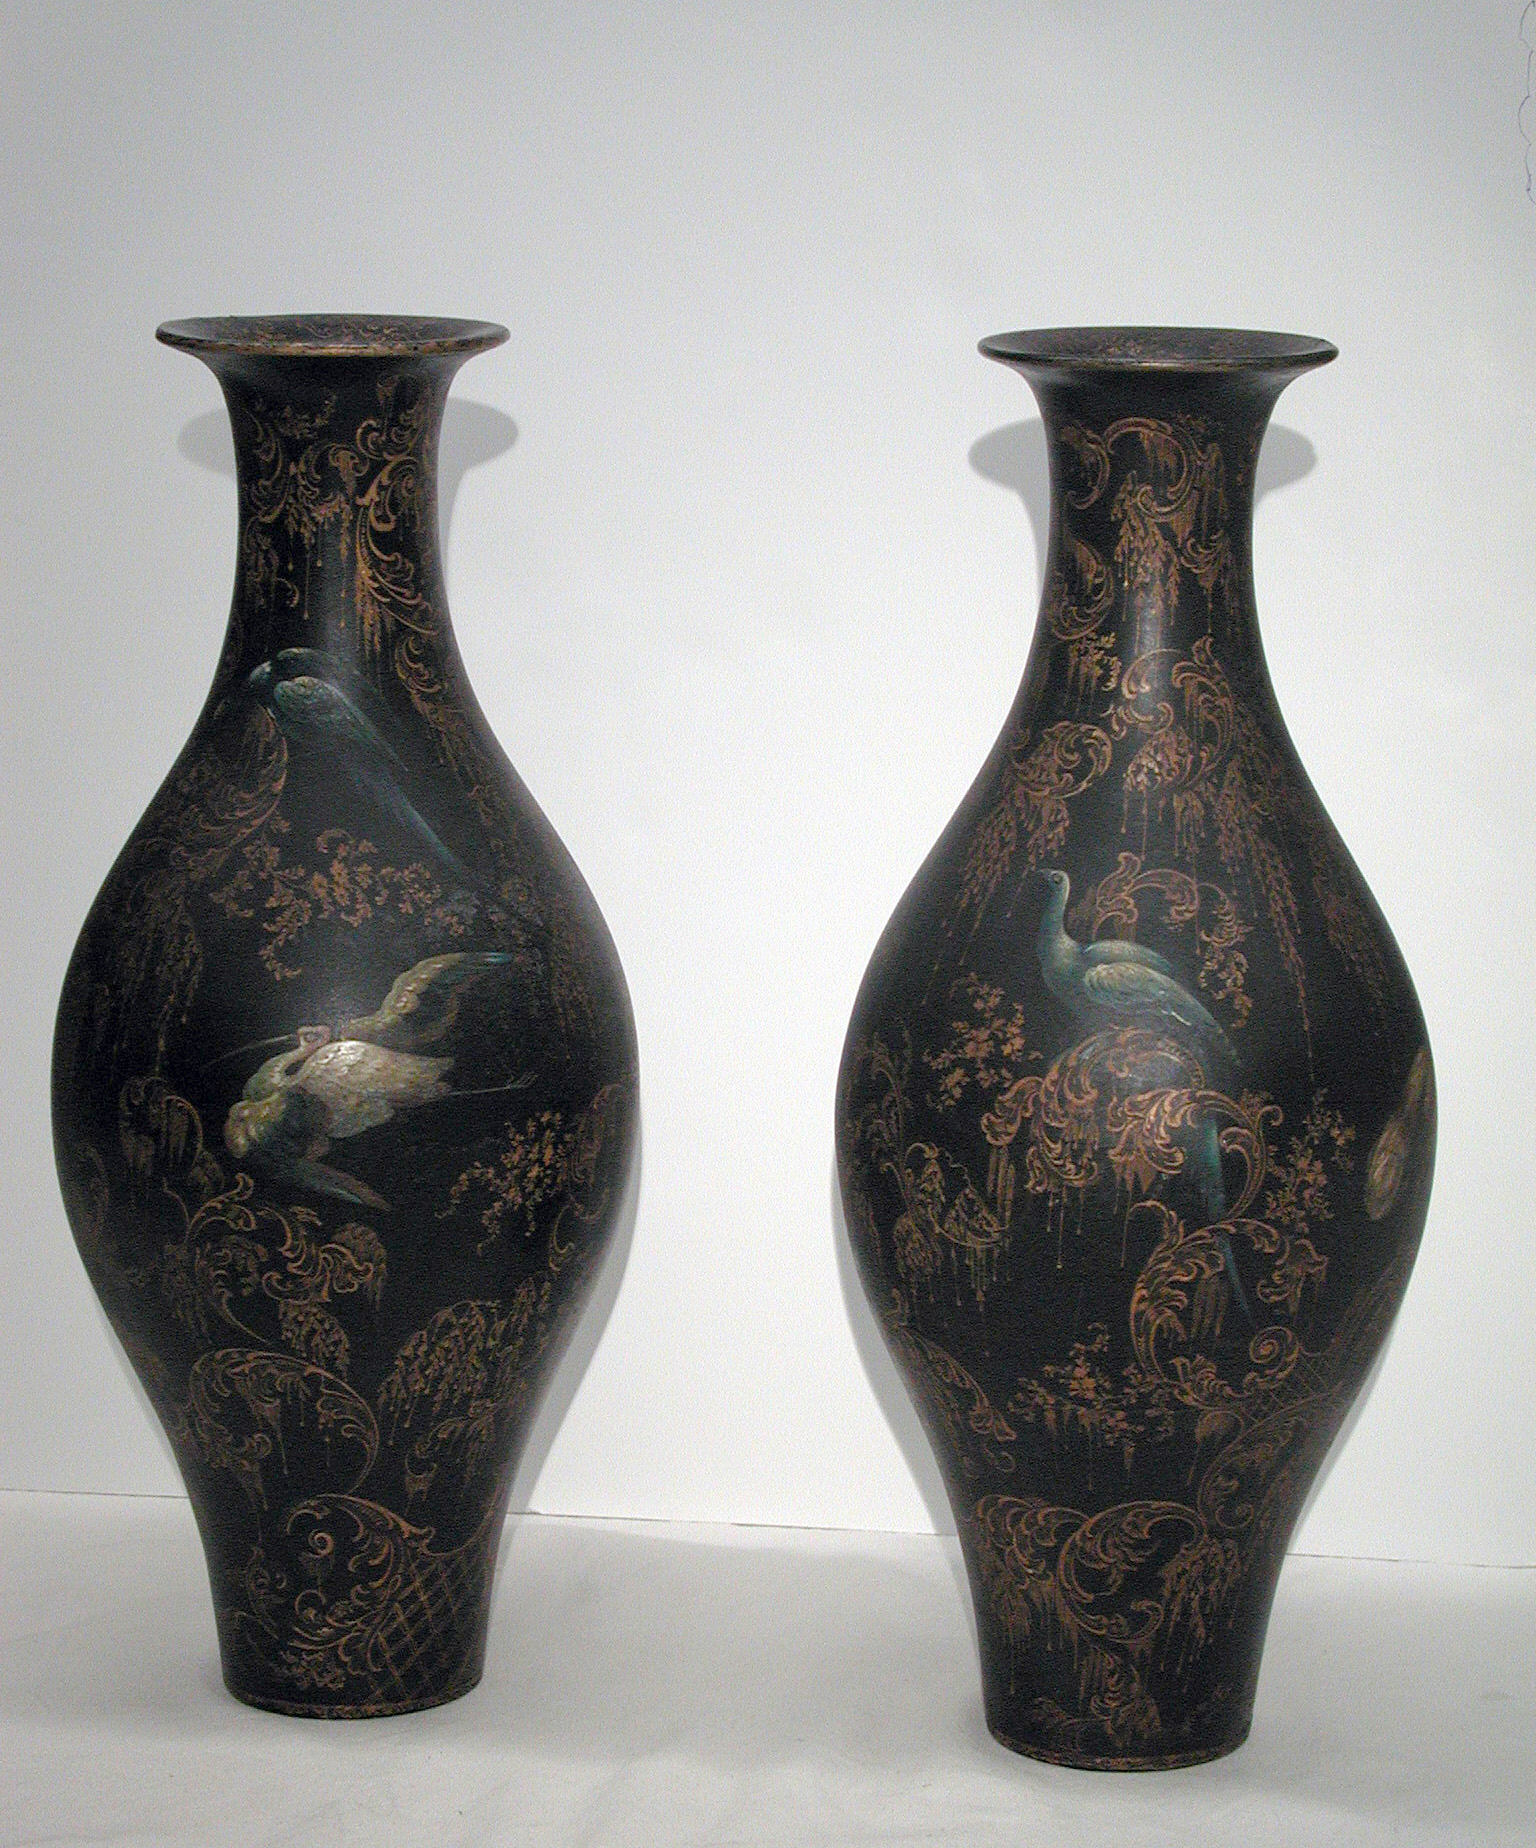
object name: vase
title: Pair of vases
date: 1834-1866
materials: paper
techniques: gilding, lacquer, painting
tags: peacocks